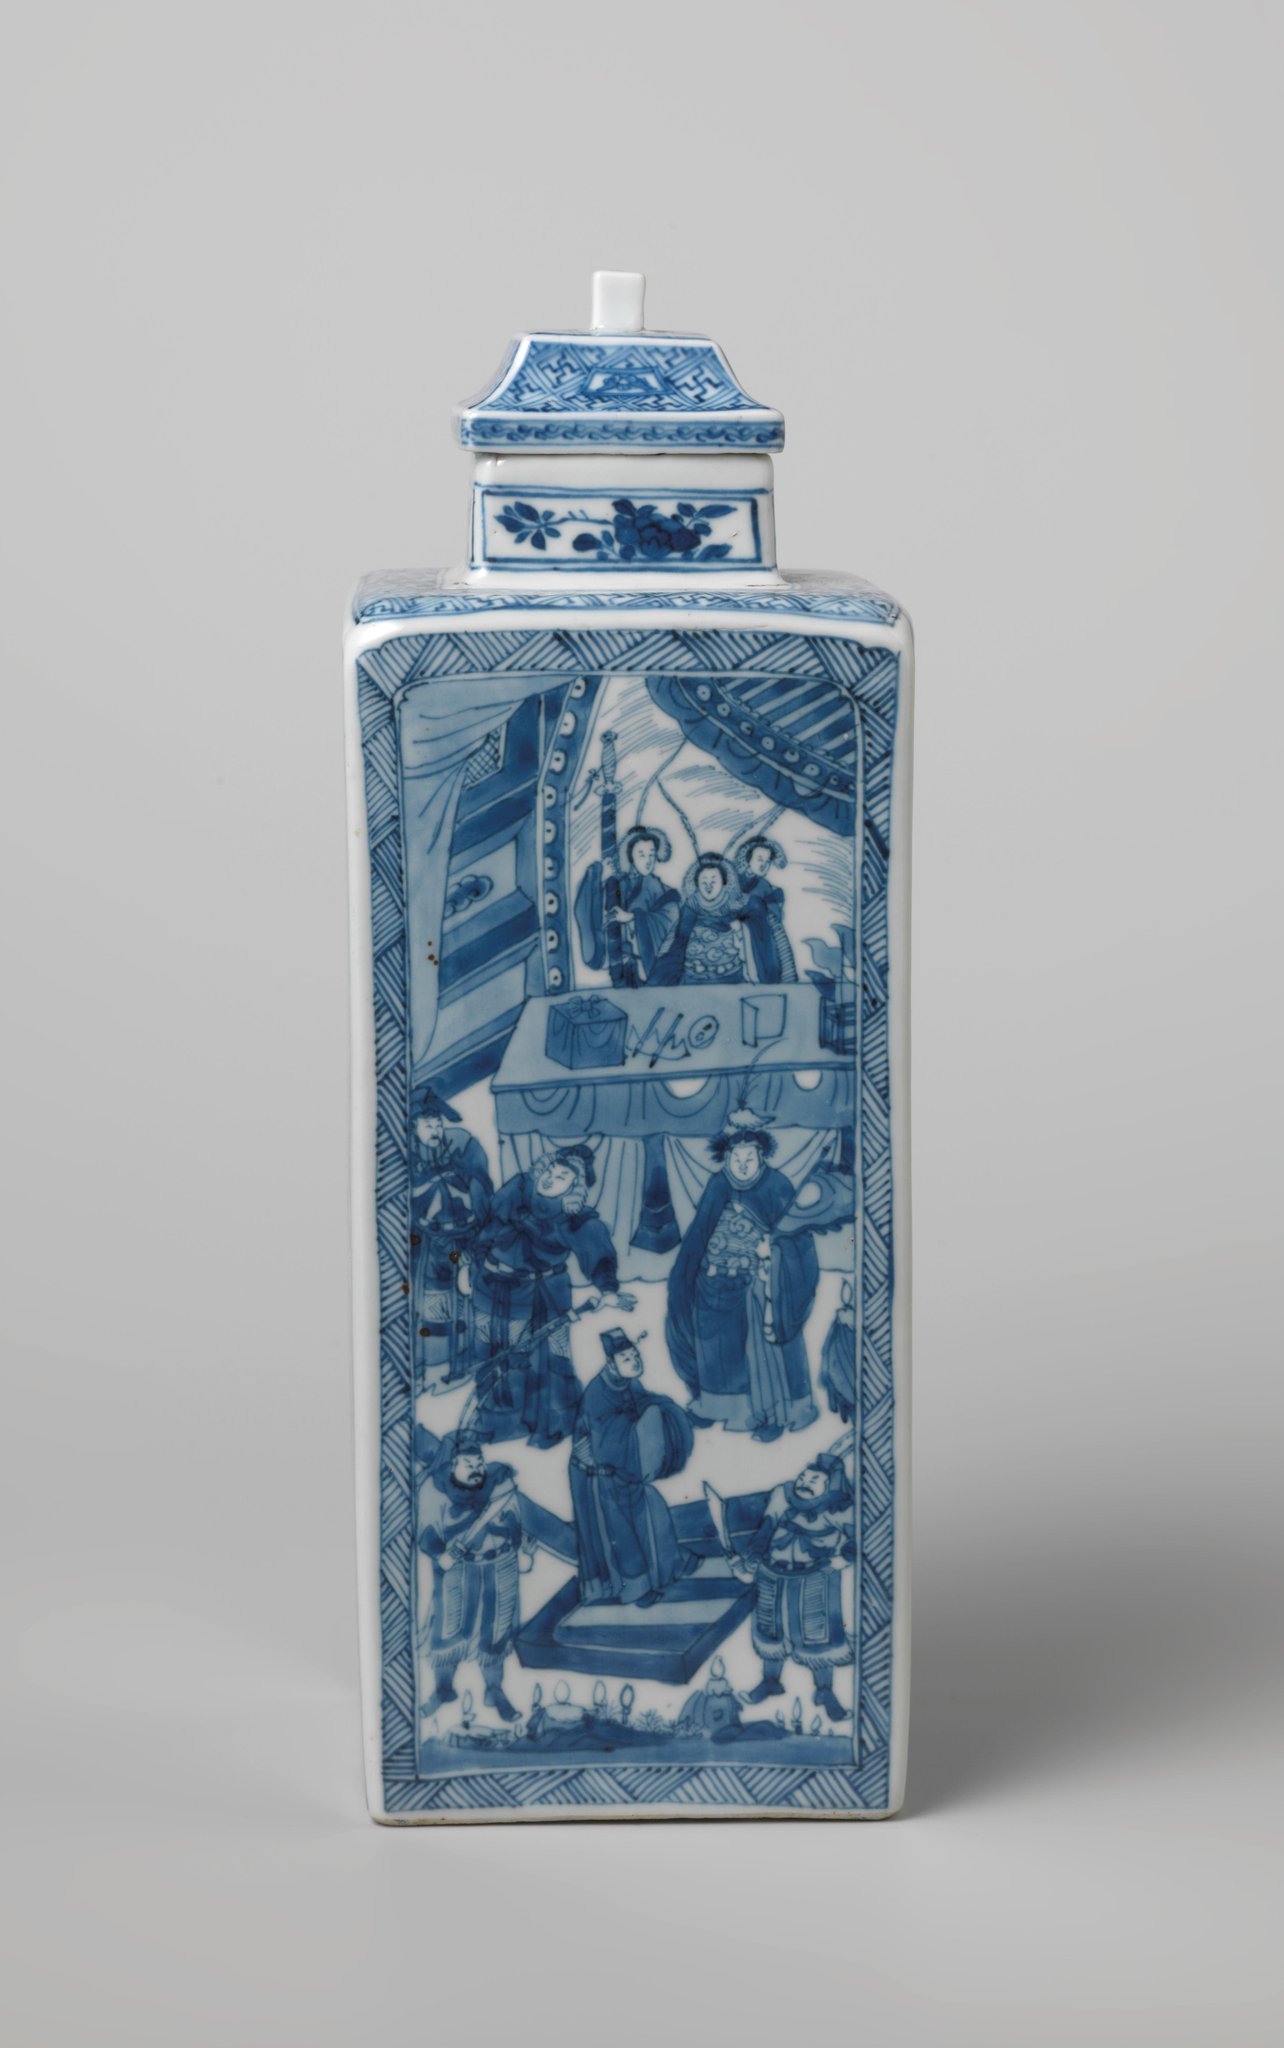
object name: lid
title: Square bottle with narrative scenes of warriors in a landschape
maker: Anonymous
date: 1675-1699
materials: cobalt, glaze, paint, porcelain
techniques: firing, forming, vitrification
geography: china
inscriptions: inscription: ‘福 Fú’, mark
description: Vierkante fles met ongeglazuurde bodem met terugspringend geglazuurde vierkant in het midden. Vierkant lichaam met vlakke schouders en vierkante nek waarop een dakvormige deksel met vierkante knop. Gedecoreerd in onderglazuur blauw met op de wanden verschillende scènes die beschilderd zijn met krijgers in een landschap in gevecht op een paard, of krijgers in een interieur staand voor een tafel waarachter zittende magistraten. Op de schouders van de vaas servetwerk; rondom de nek bloesemtakken. Op de deksel het karakter 'Fu', die staat voor geluk. Gemerkt op het terugspringende geglazuurde vierkant in het midden van de bodem een artemisiablad.